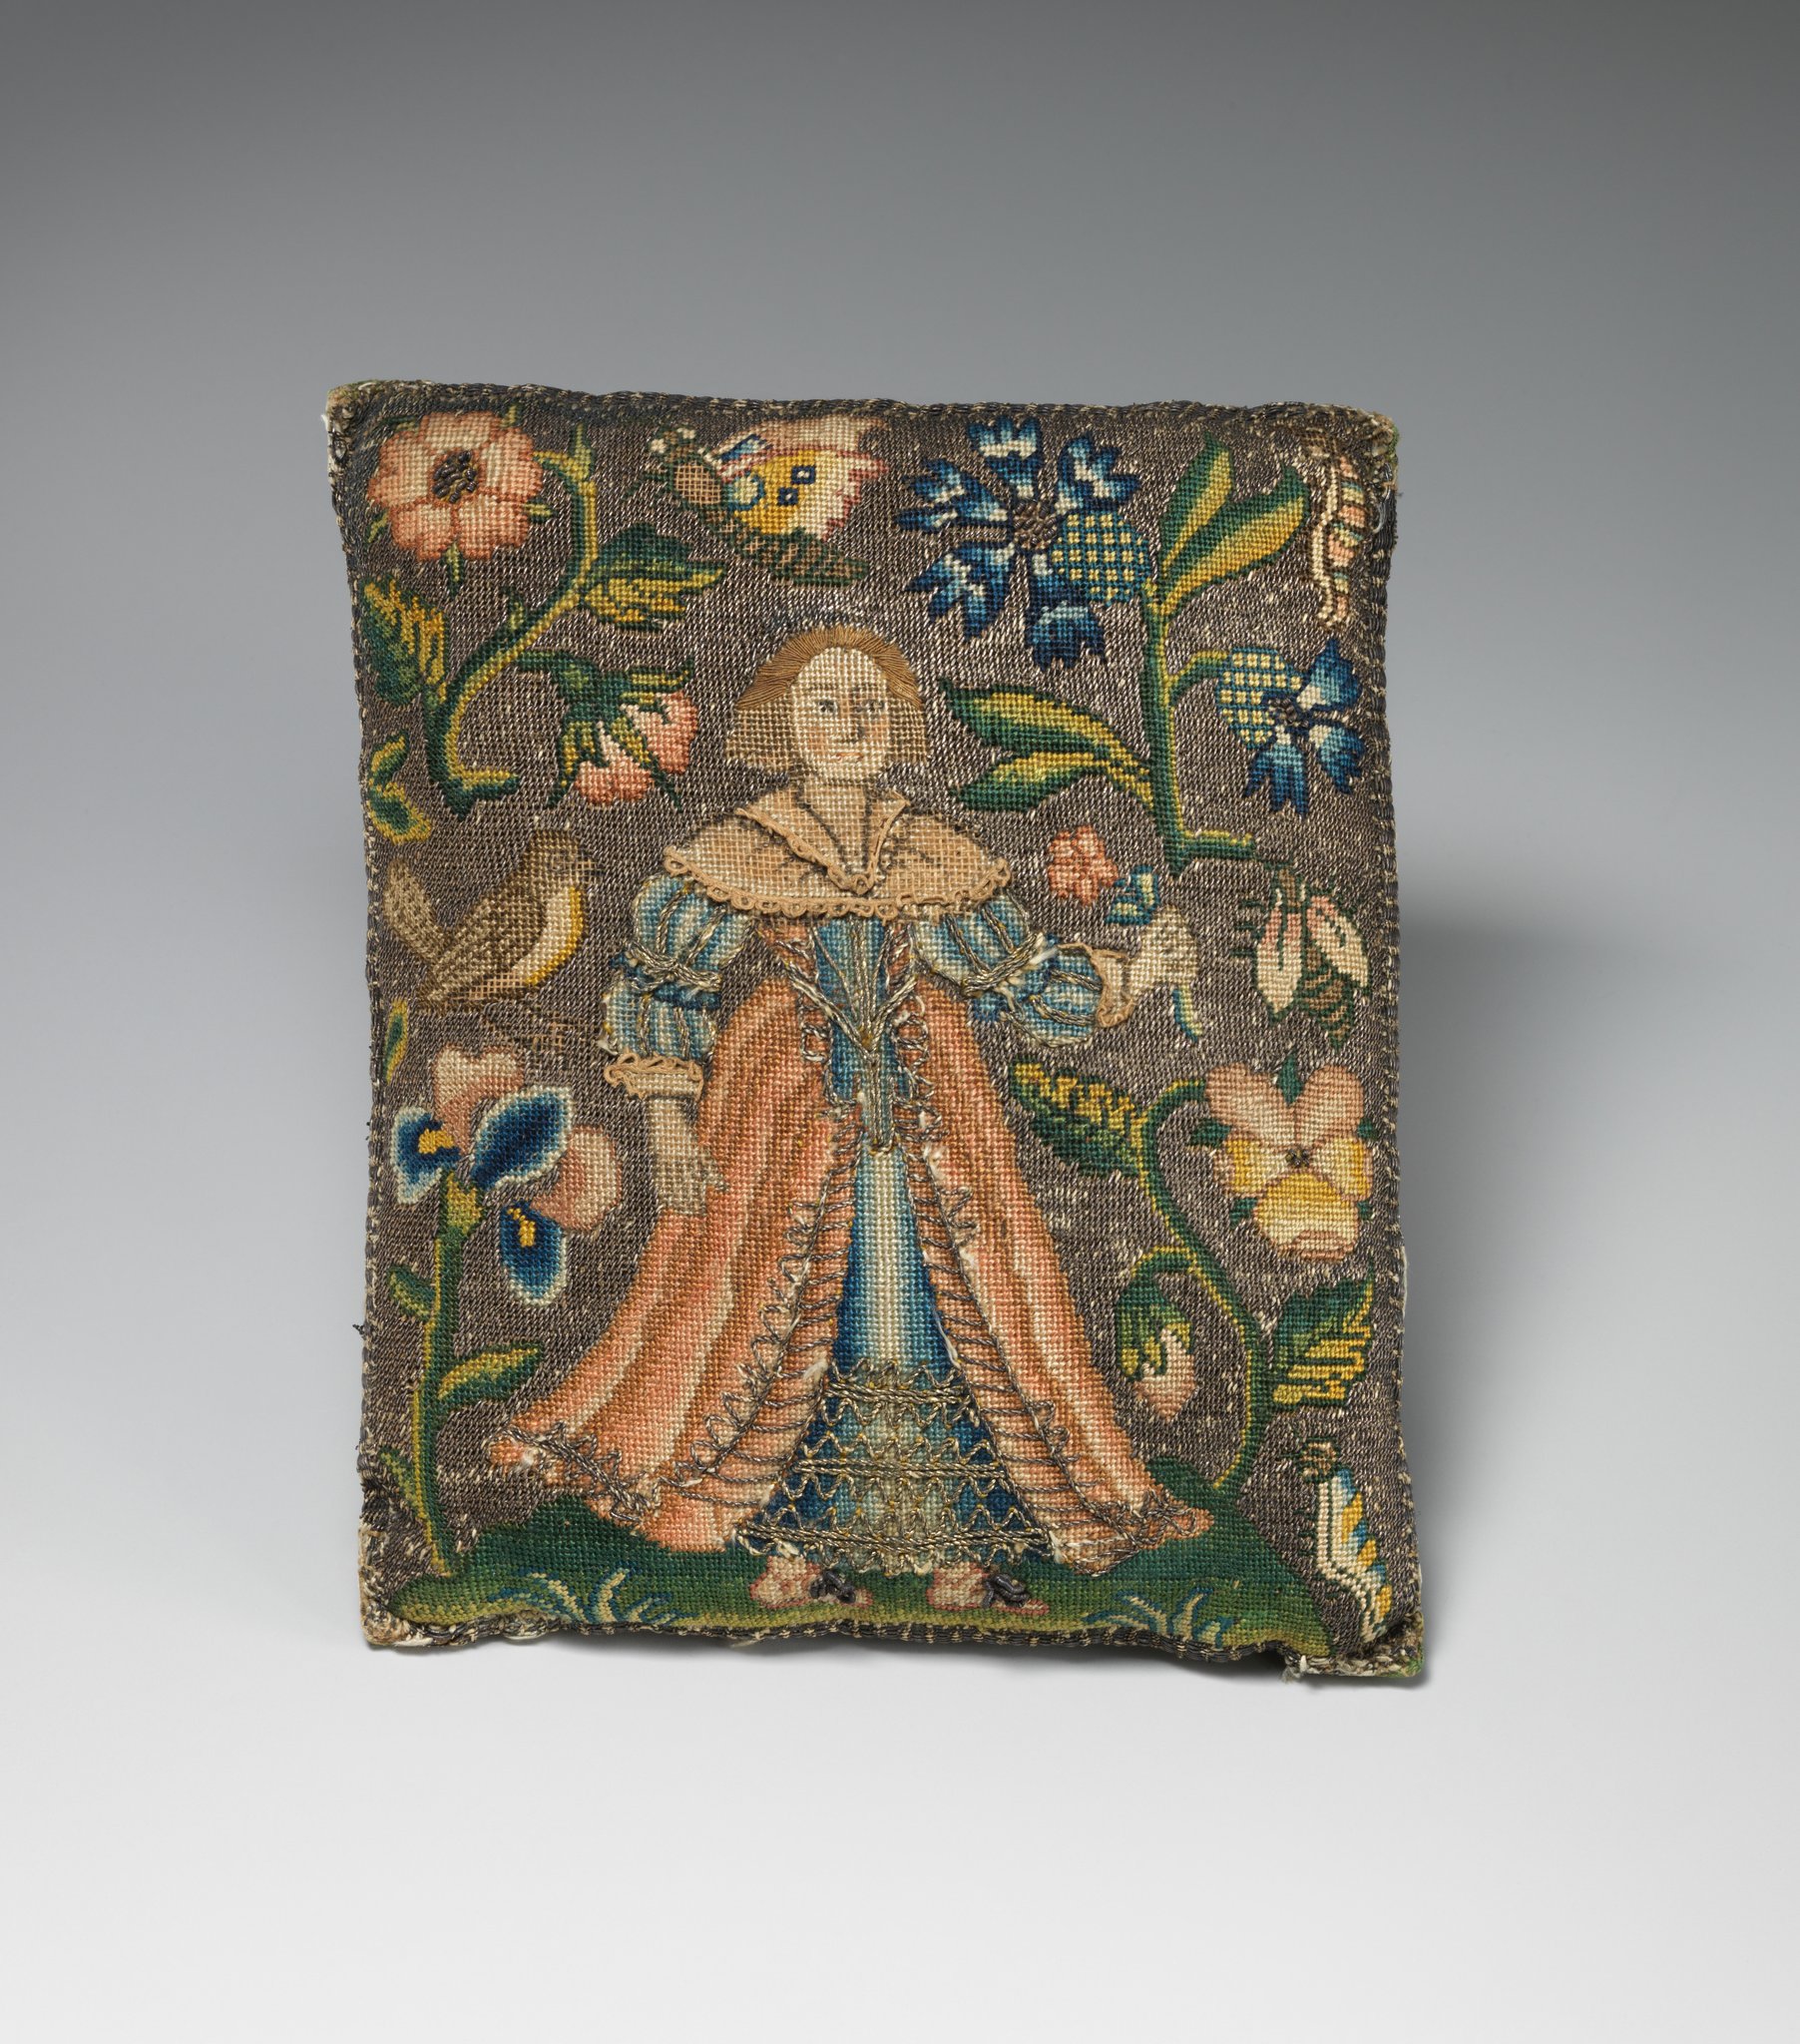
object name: cushion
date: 1634-1666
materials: canvas, metal thread, silk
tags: birds,women,flowers